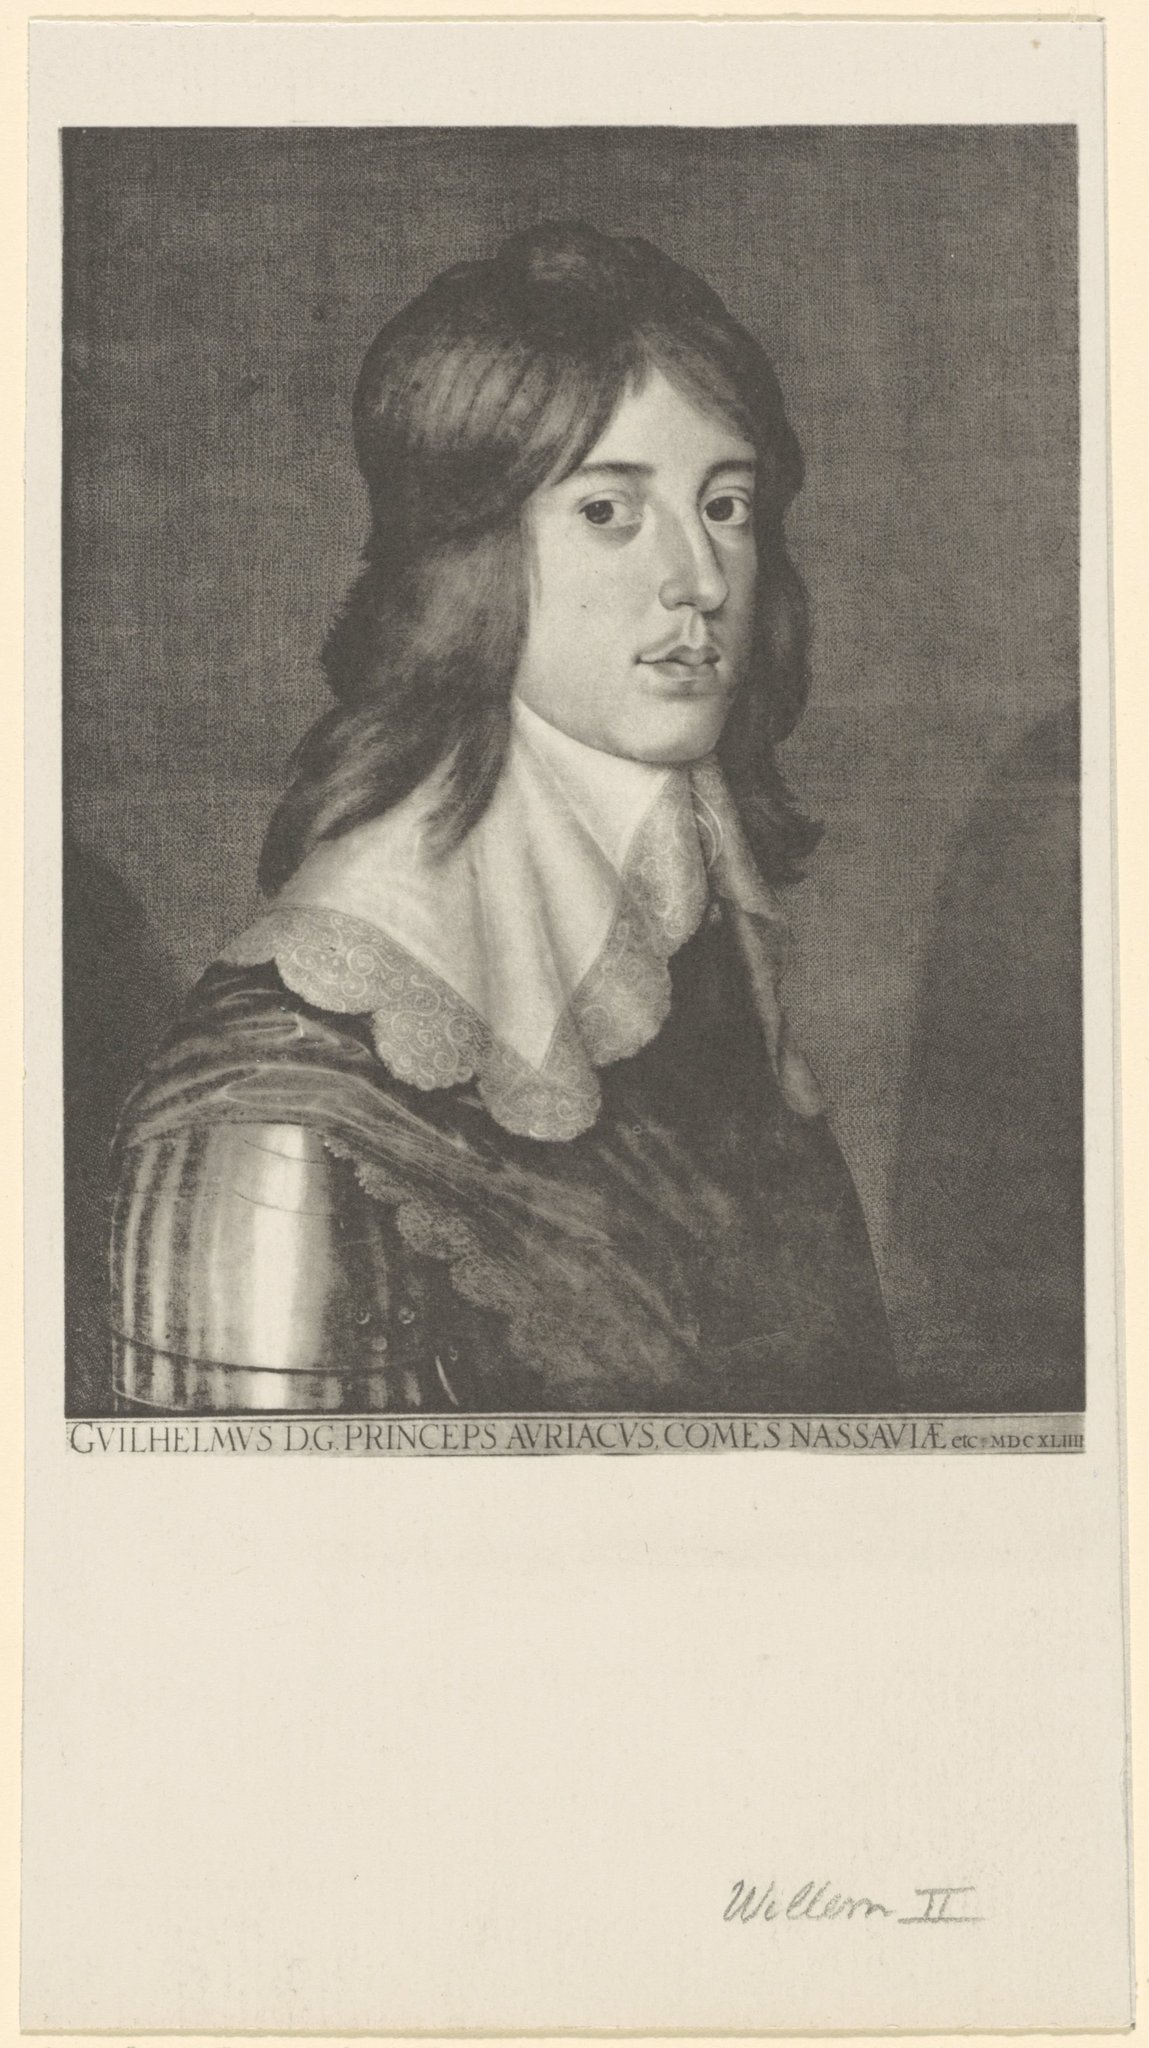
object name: photomechanical print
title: Portret van Willem II, prins van Oranje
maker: Anonymous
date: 1850-1949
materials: paper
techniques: photograph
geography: netherlands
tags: william ii (prince of orange)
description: De hier vermelde titel verwijst naar de hoogst verkregen titel van de geportretteerde, niet per se naar de titel die de geportretteerde op deze voorstelling draagt.